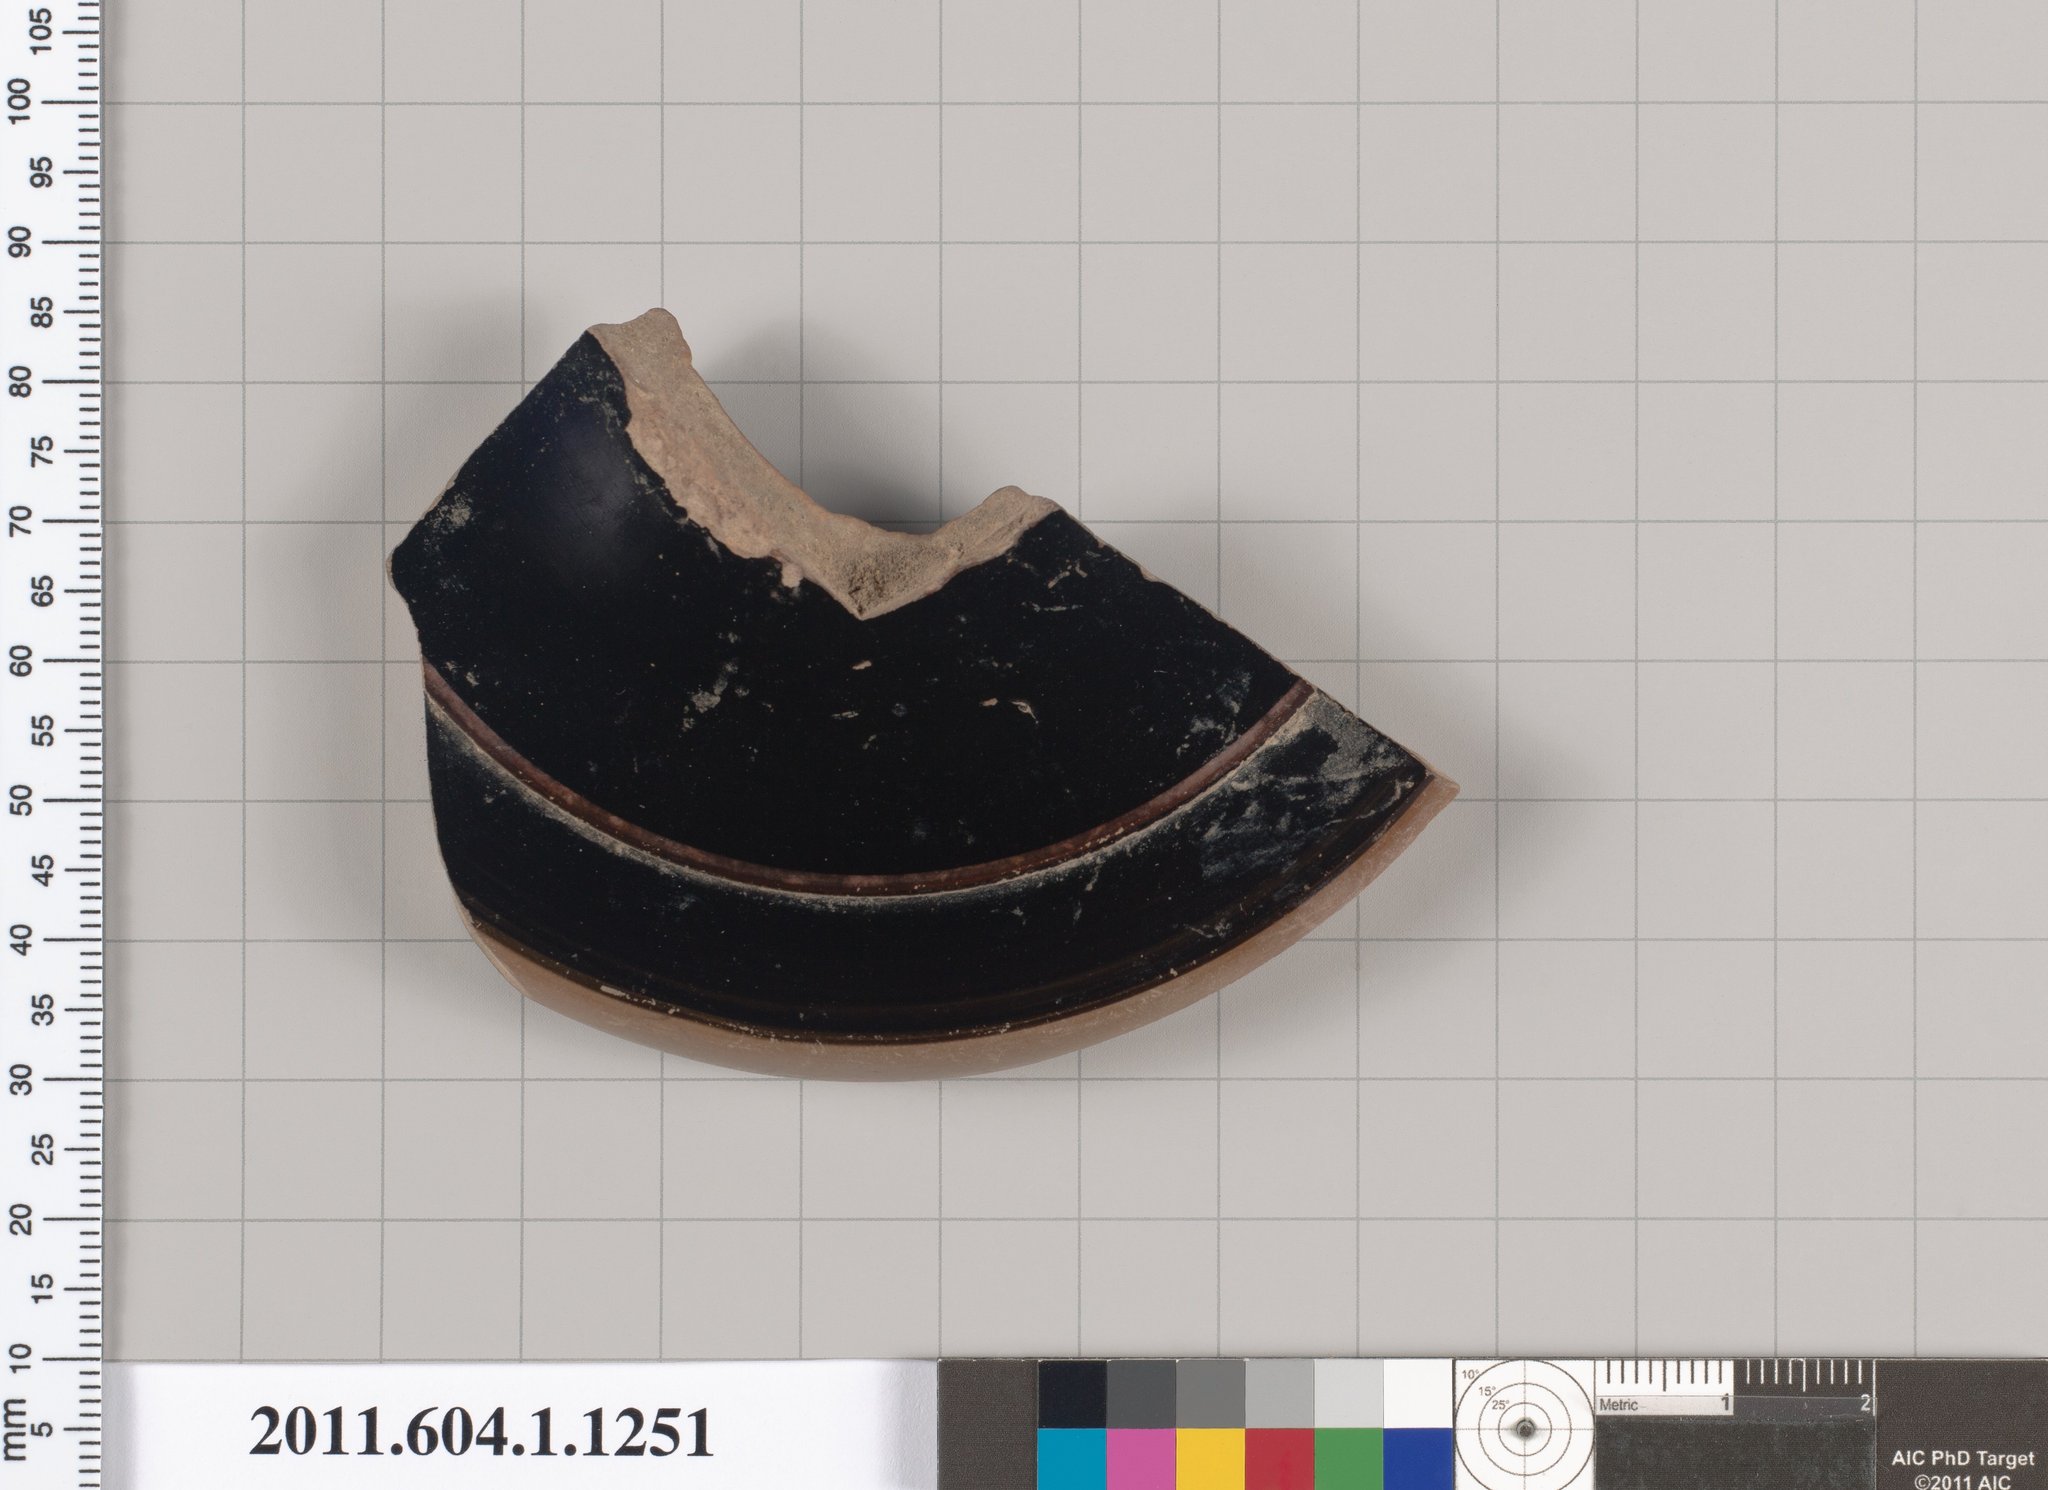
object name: kylix fragment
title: Terracotta fragment of a kylix (drinking cup)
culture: greek, attic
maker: douris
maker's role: artist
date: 490-480 BCE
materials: terracotta